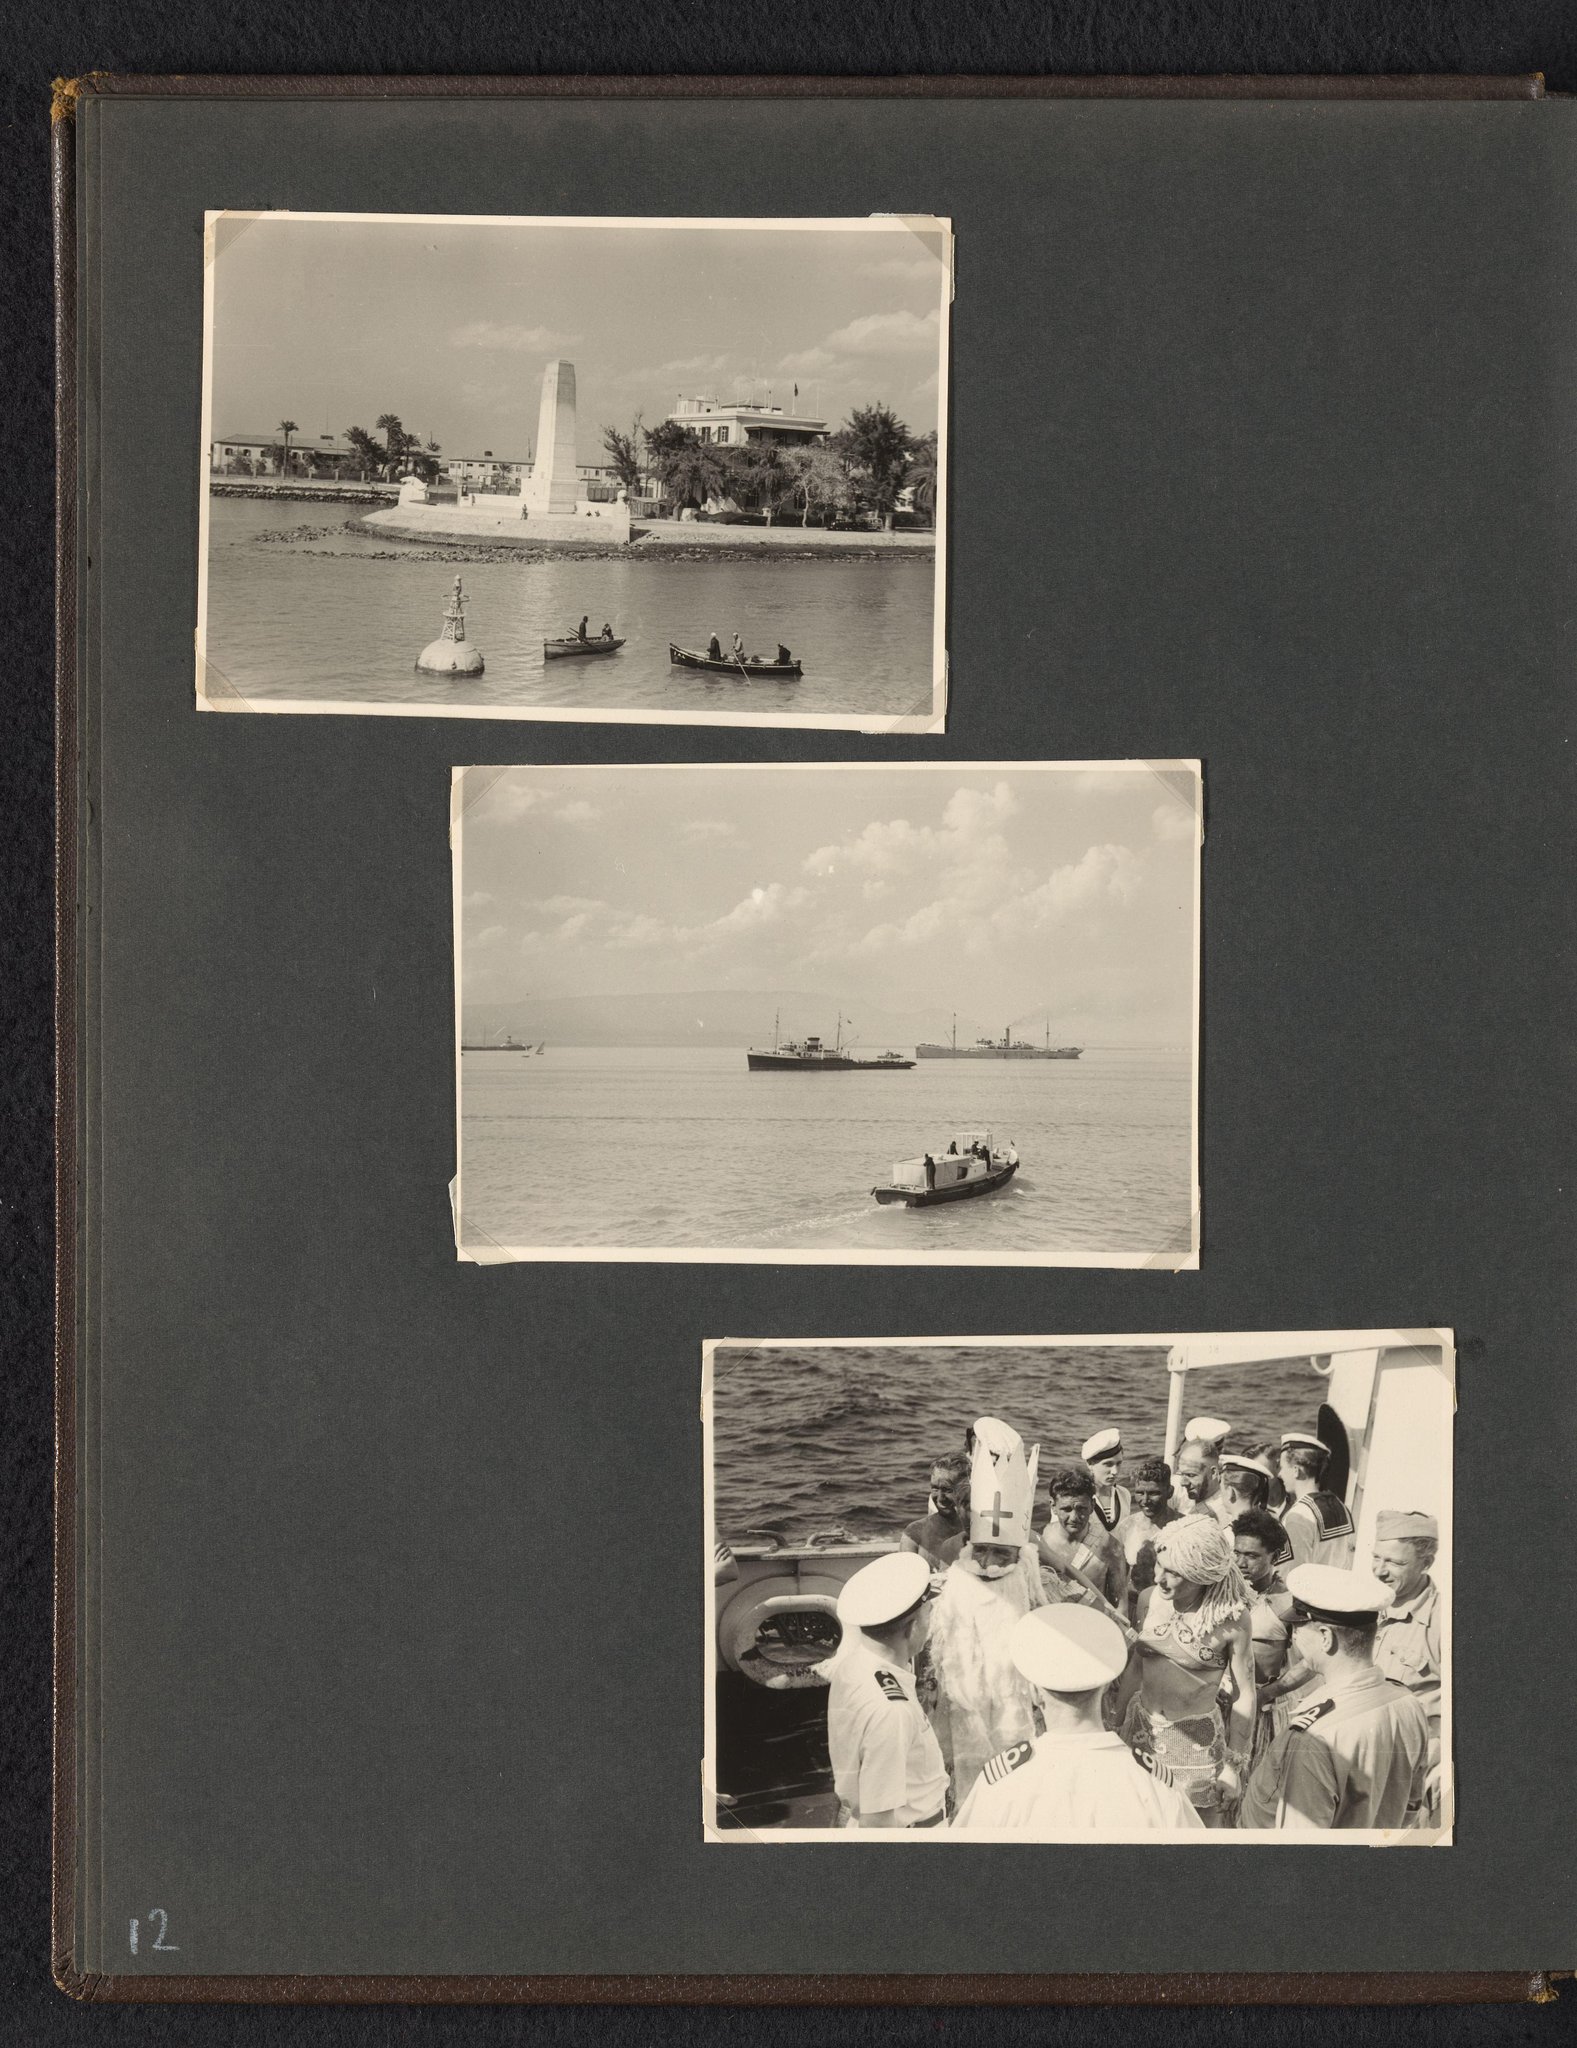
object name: album leaf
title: Suezkanaal en evenaar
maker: Anonymous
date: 1947-1948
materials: cardboard, photographic support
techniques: gelatin silver print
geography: suez canal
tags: troop movements, transportation, the company, the unit, the troop ~ military service, man dressed as woman, travesty, celebration on board while crossing the equator (neptune), canal, steamship, motorship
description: Albumblad met drie foto's tijdens de doorvaart van het Suezkanaal, genomen vanaf de S.S. Waterman op weg naar Nederlands-Indië, en van de ceremonie aan boord van het schip bij het passeren van de evenaar. Onderdeel van het fotoalbum 'Mijn jaren in Indië' met foto's over de militaire acties in Nederlands-Indië.